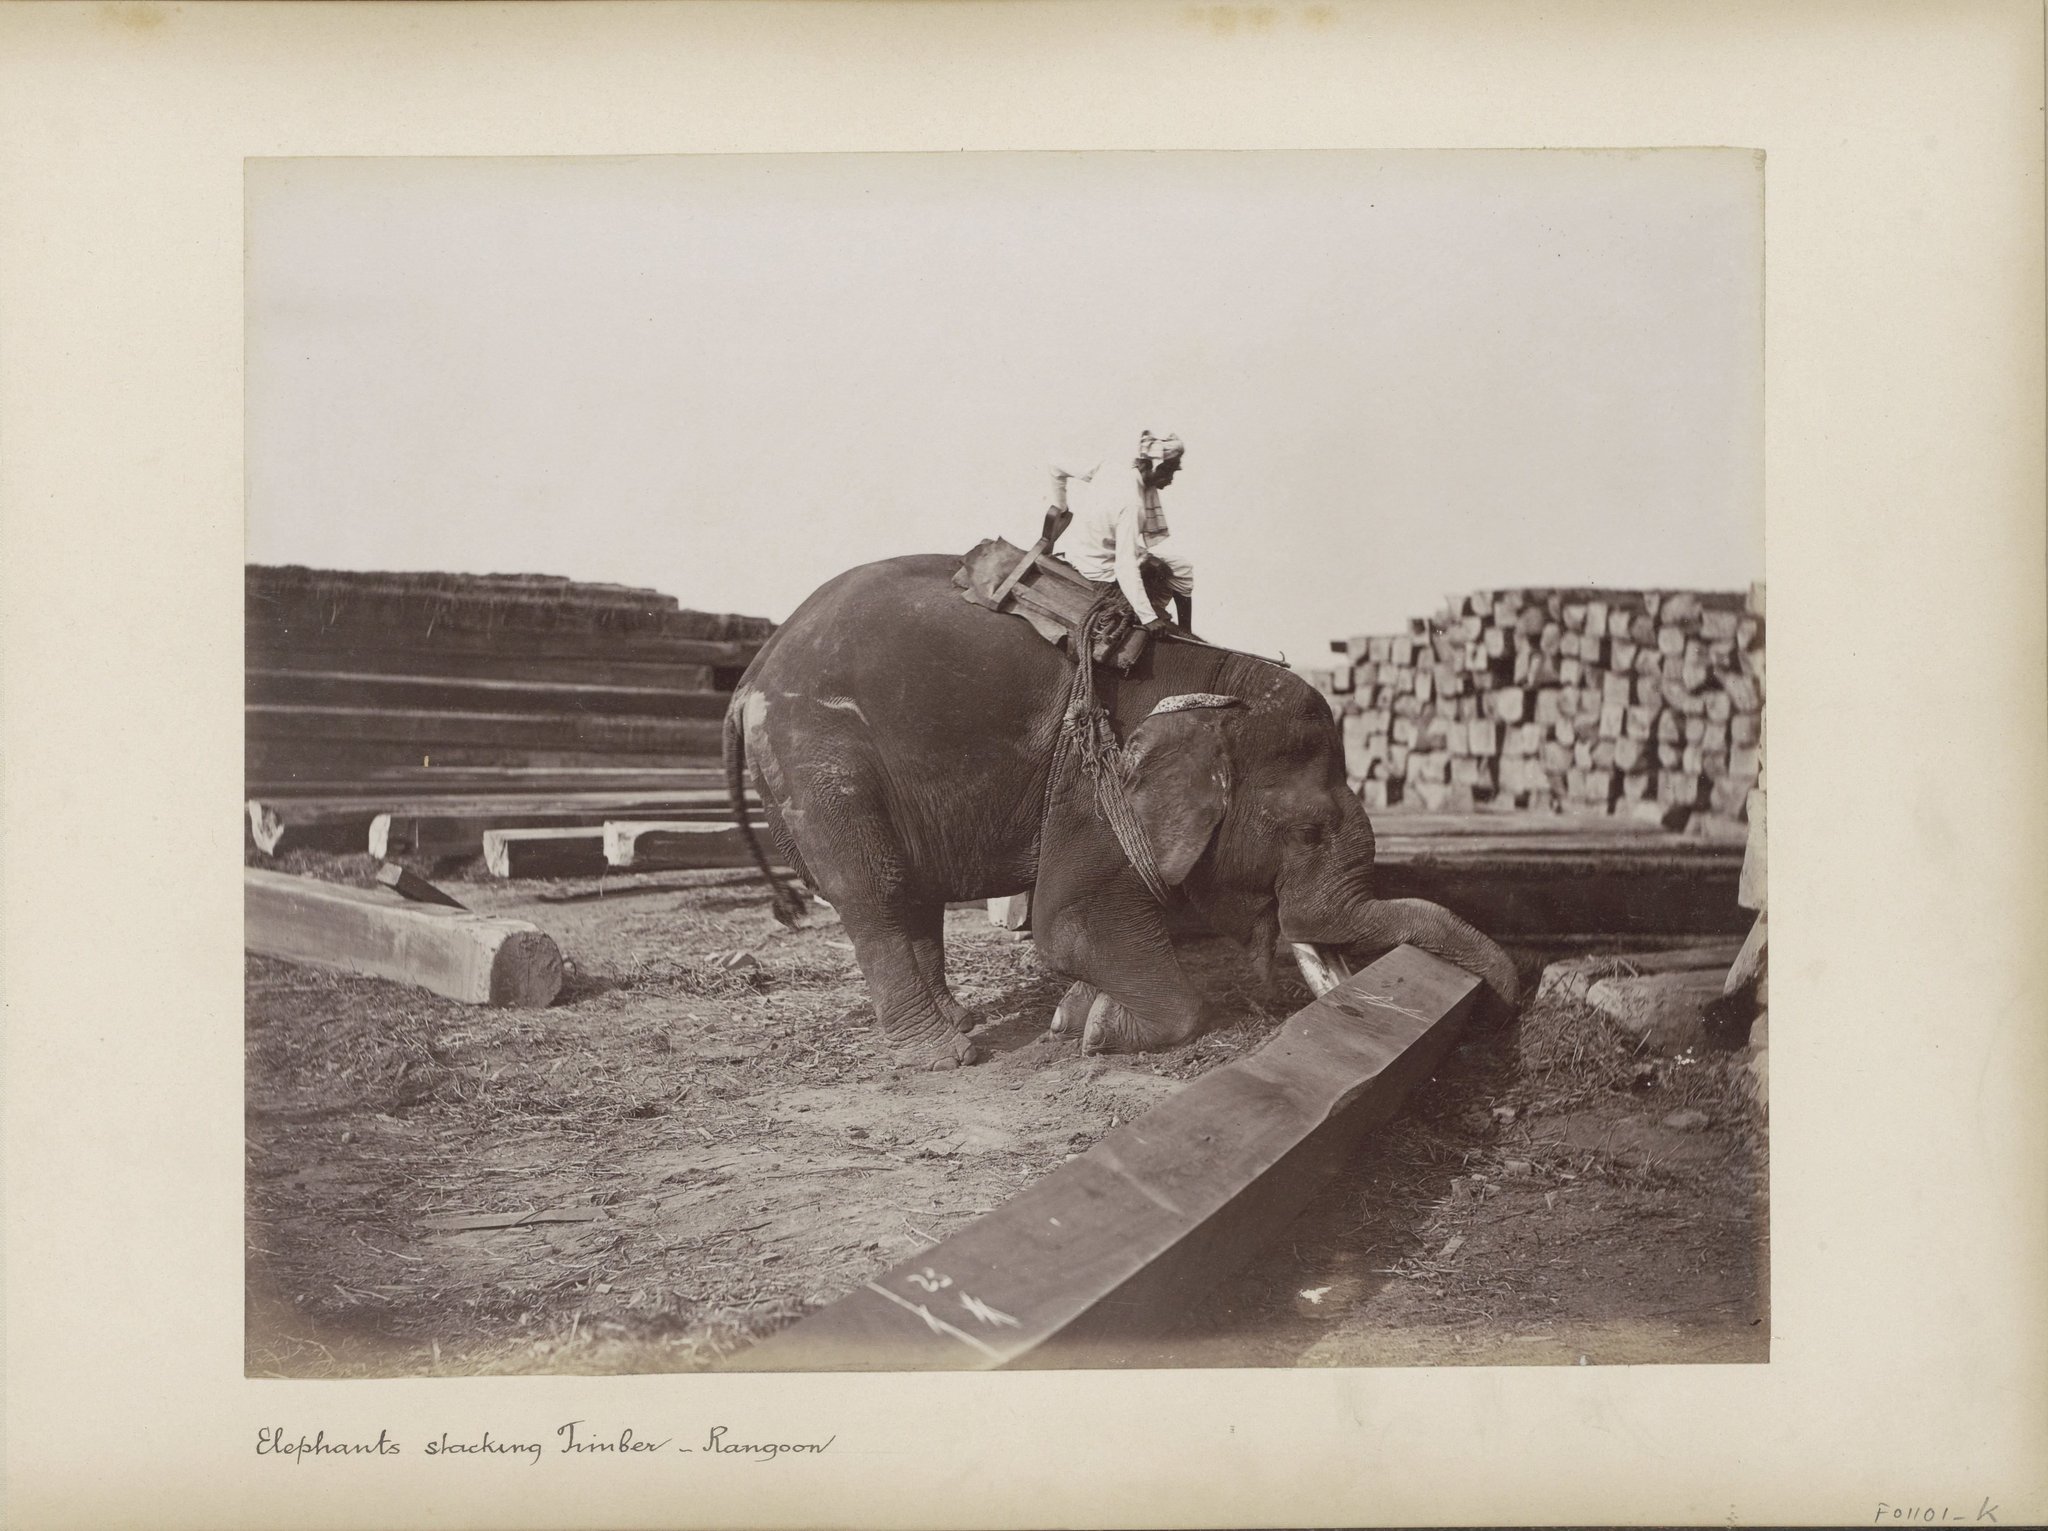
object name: photograph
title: An elephant working in the timber extraction at Yangon, Myanmar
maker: philip adolphe klier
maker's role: fotograaf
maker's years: 1845-1911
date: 1885-1886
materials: cardboard, paper, photographic support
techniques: albumen print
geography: yangon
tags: transport of timber, timber-trailer, trunked animals: elephant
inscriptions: caption: ‘Elephants stacking Timber - Rangoon’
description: Onderdeel van Reisalbum met foto's van bezienswaardigheden in Birma.